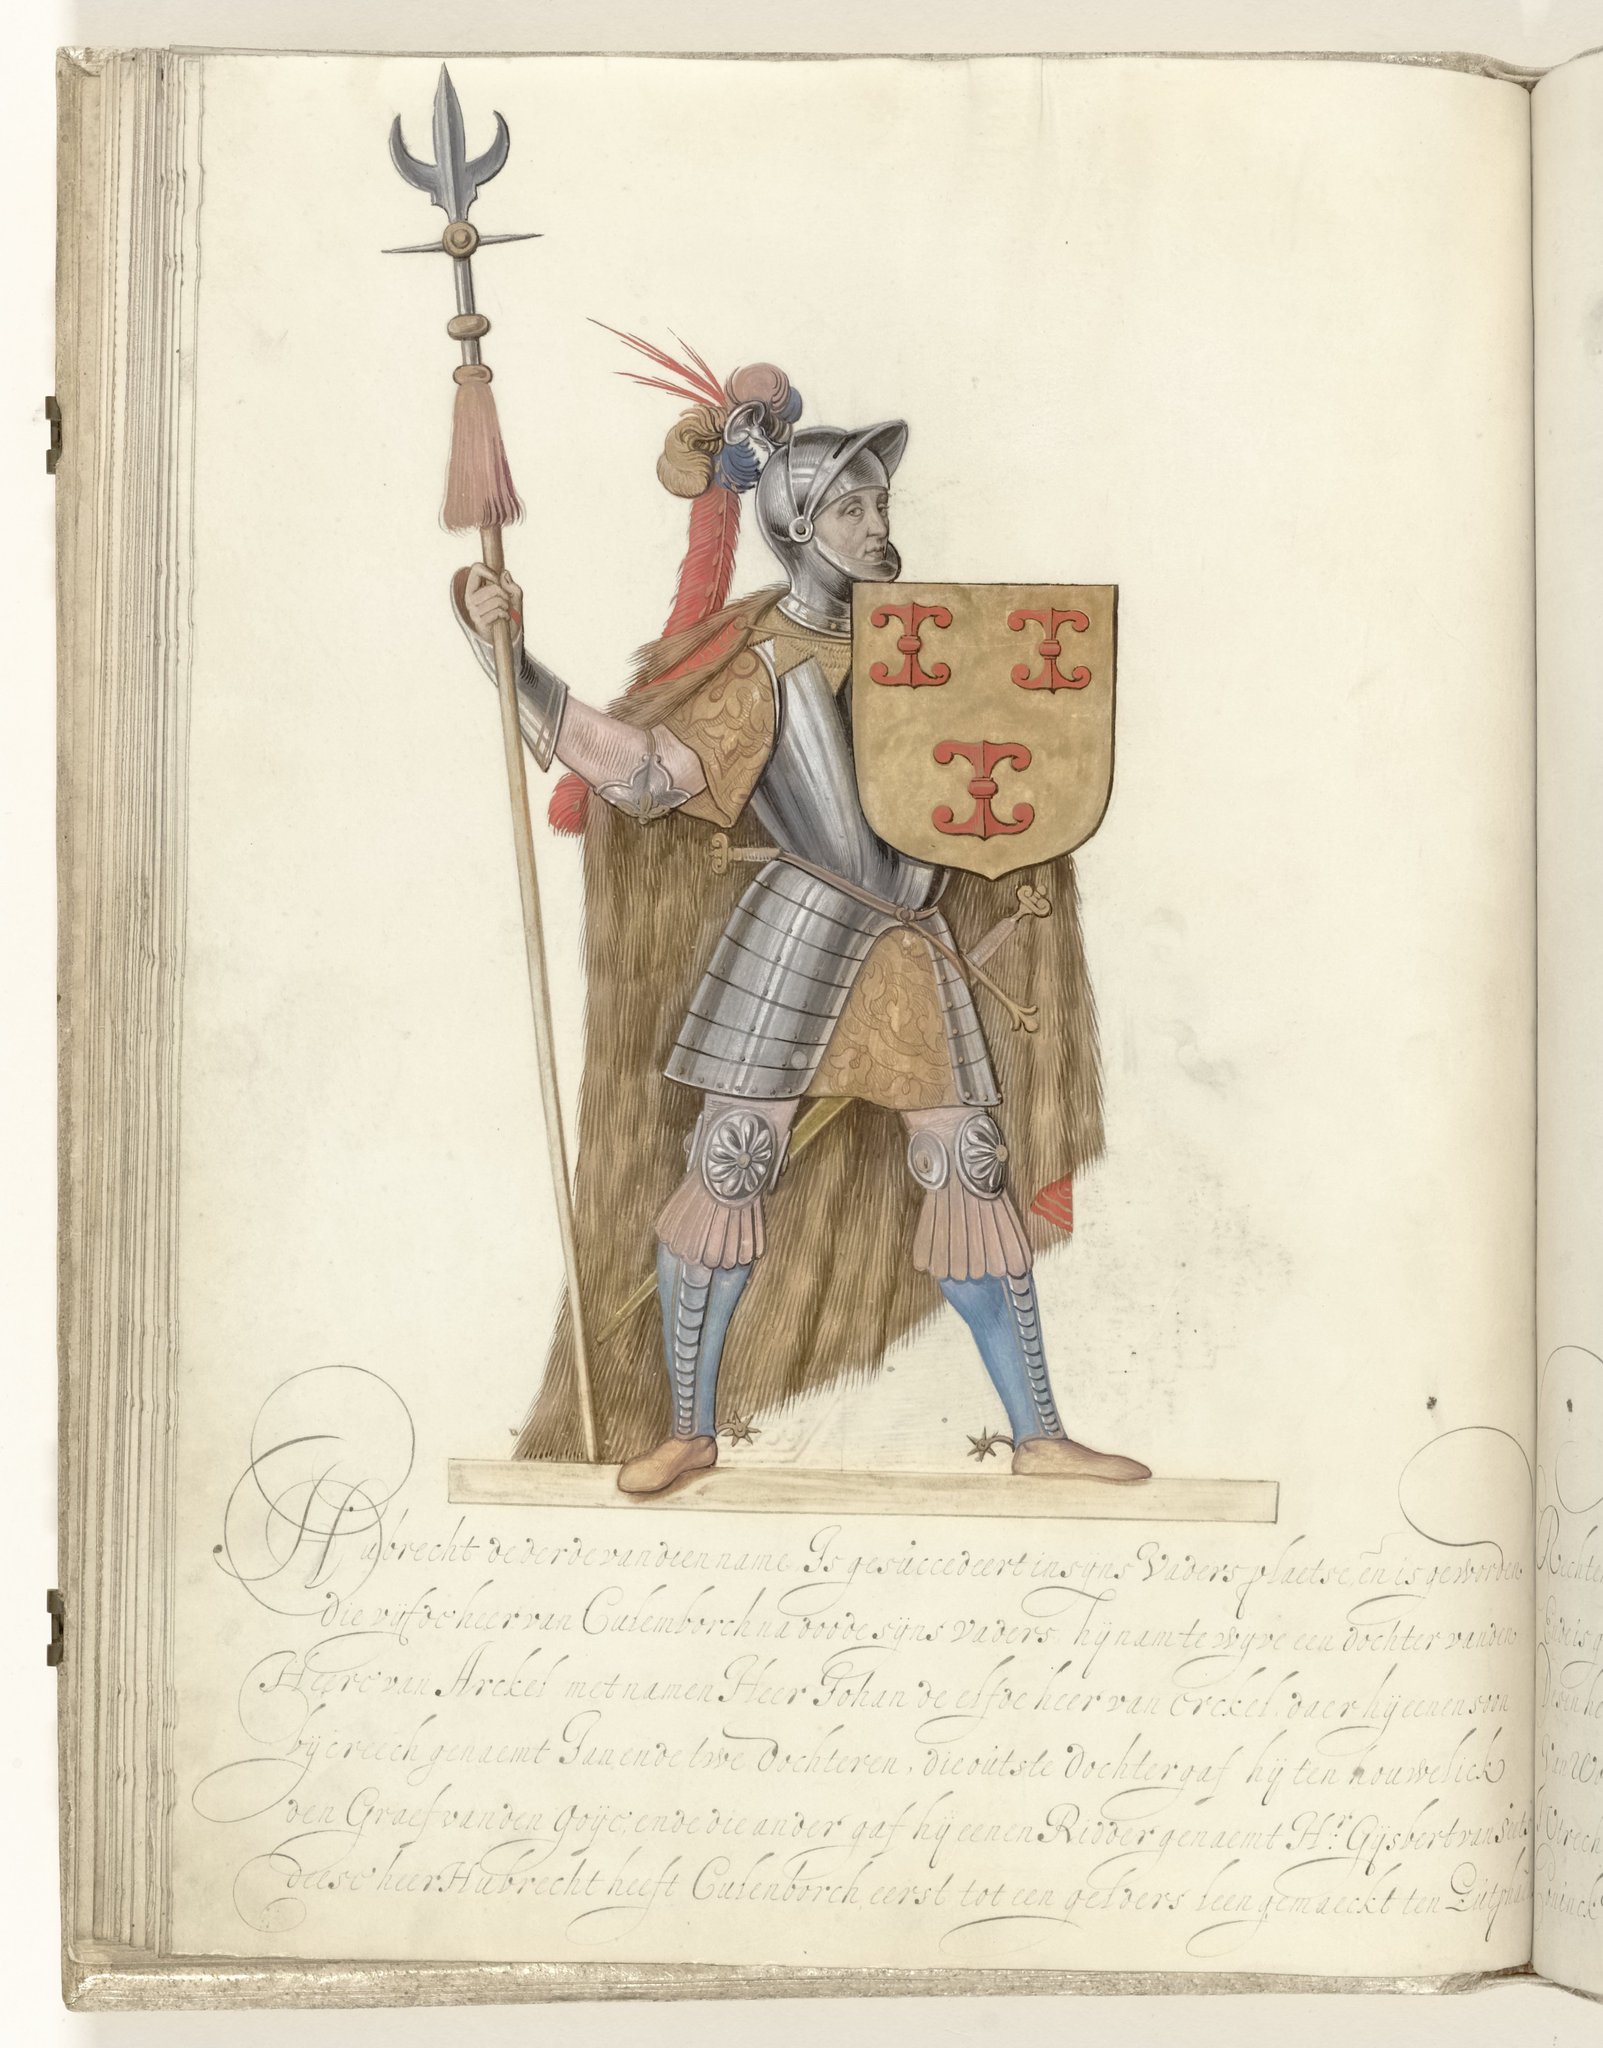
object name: drawing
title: Hubrecht III van Bosinchem, heer van Culemborg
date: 1590-1593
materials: paint, gouache, ink, parchment, watercolor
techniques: writing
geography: northern netherlands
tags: culemborg, heren en graven van, heren van beusichem, hubrecht van bosinchem heer van culemborg (iii), culemborg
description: Hubrecht III van Bosinchem, vijfde heer van Culemborg. Staande ten voeten uit, in wapenrusting met een hellebaard in de rechterhand en het wapen van Culemborg als schild in de linkerhand. Onderdeel van een geïllustreerd handschrift met de genealogie van de heren en graven van Culemborg.